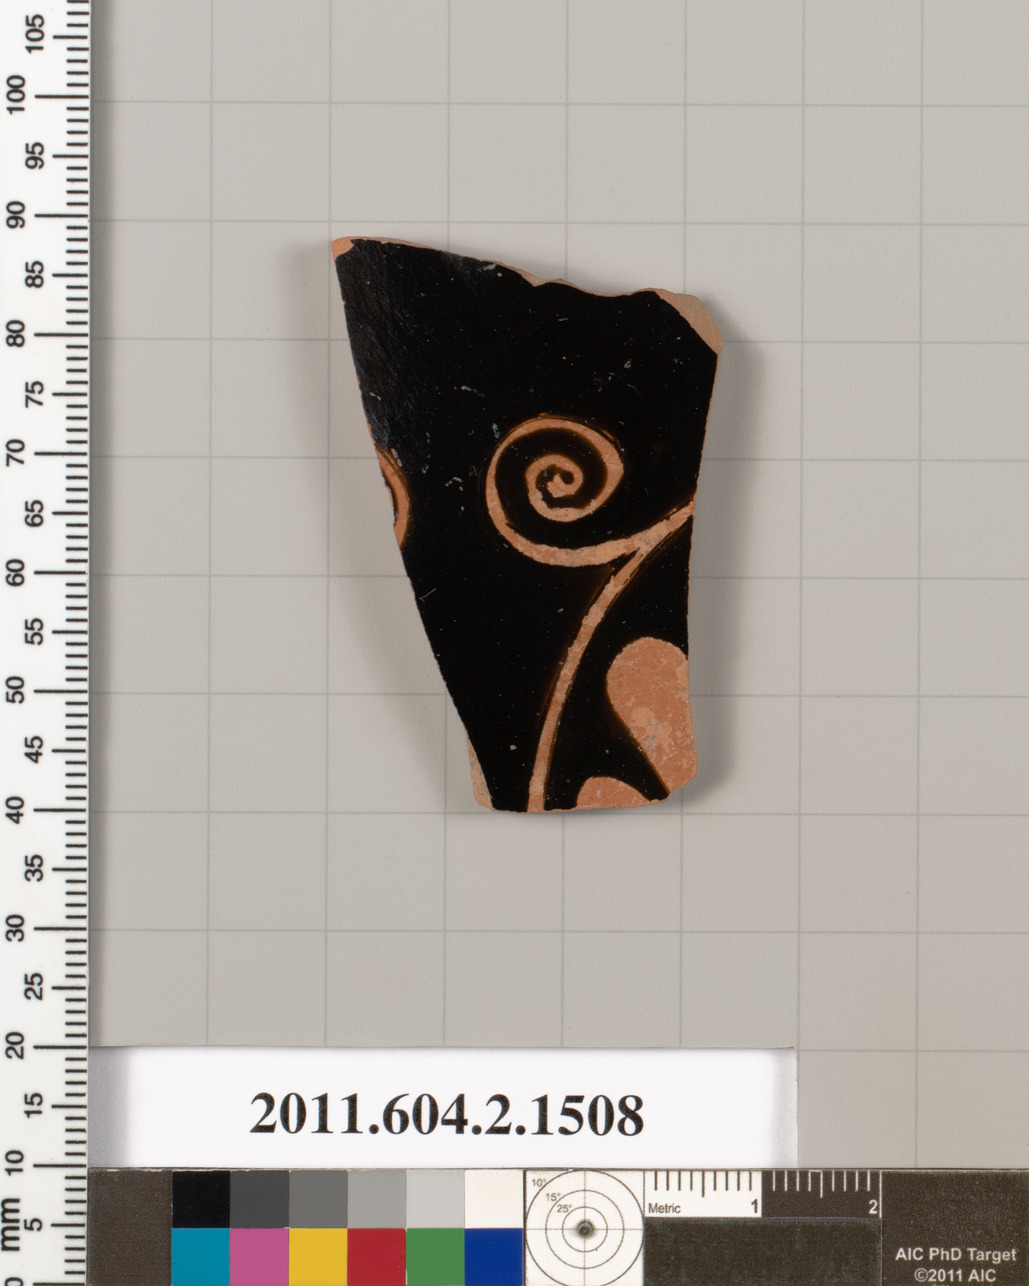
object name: skyphos fragment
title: Terracotta fragment of a skyphos (deep drinking cup)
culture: greek, attic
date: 490-470 BCE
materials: terracotta